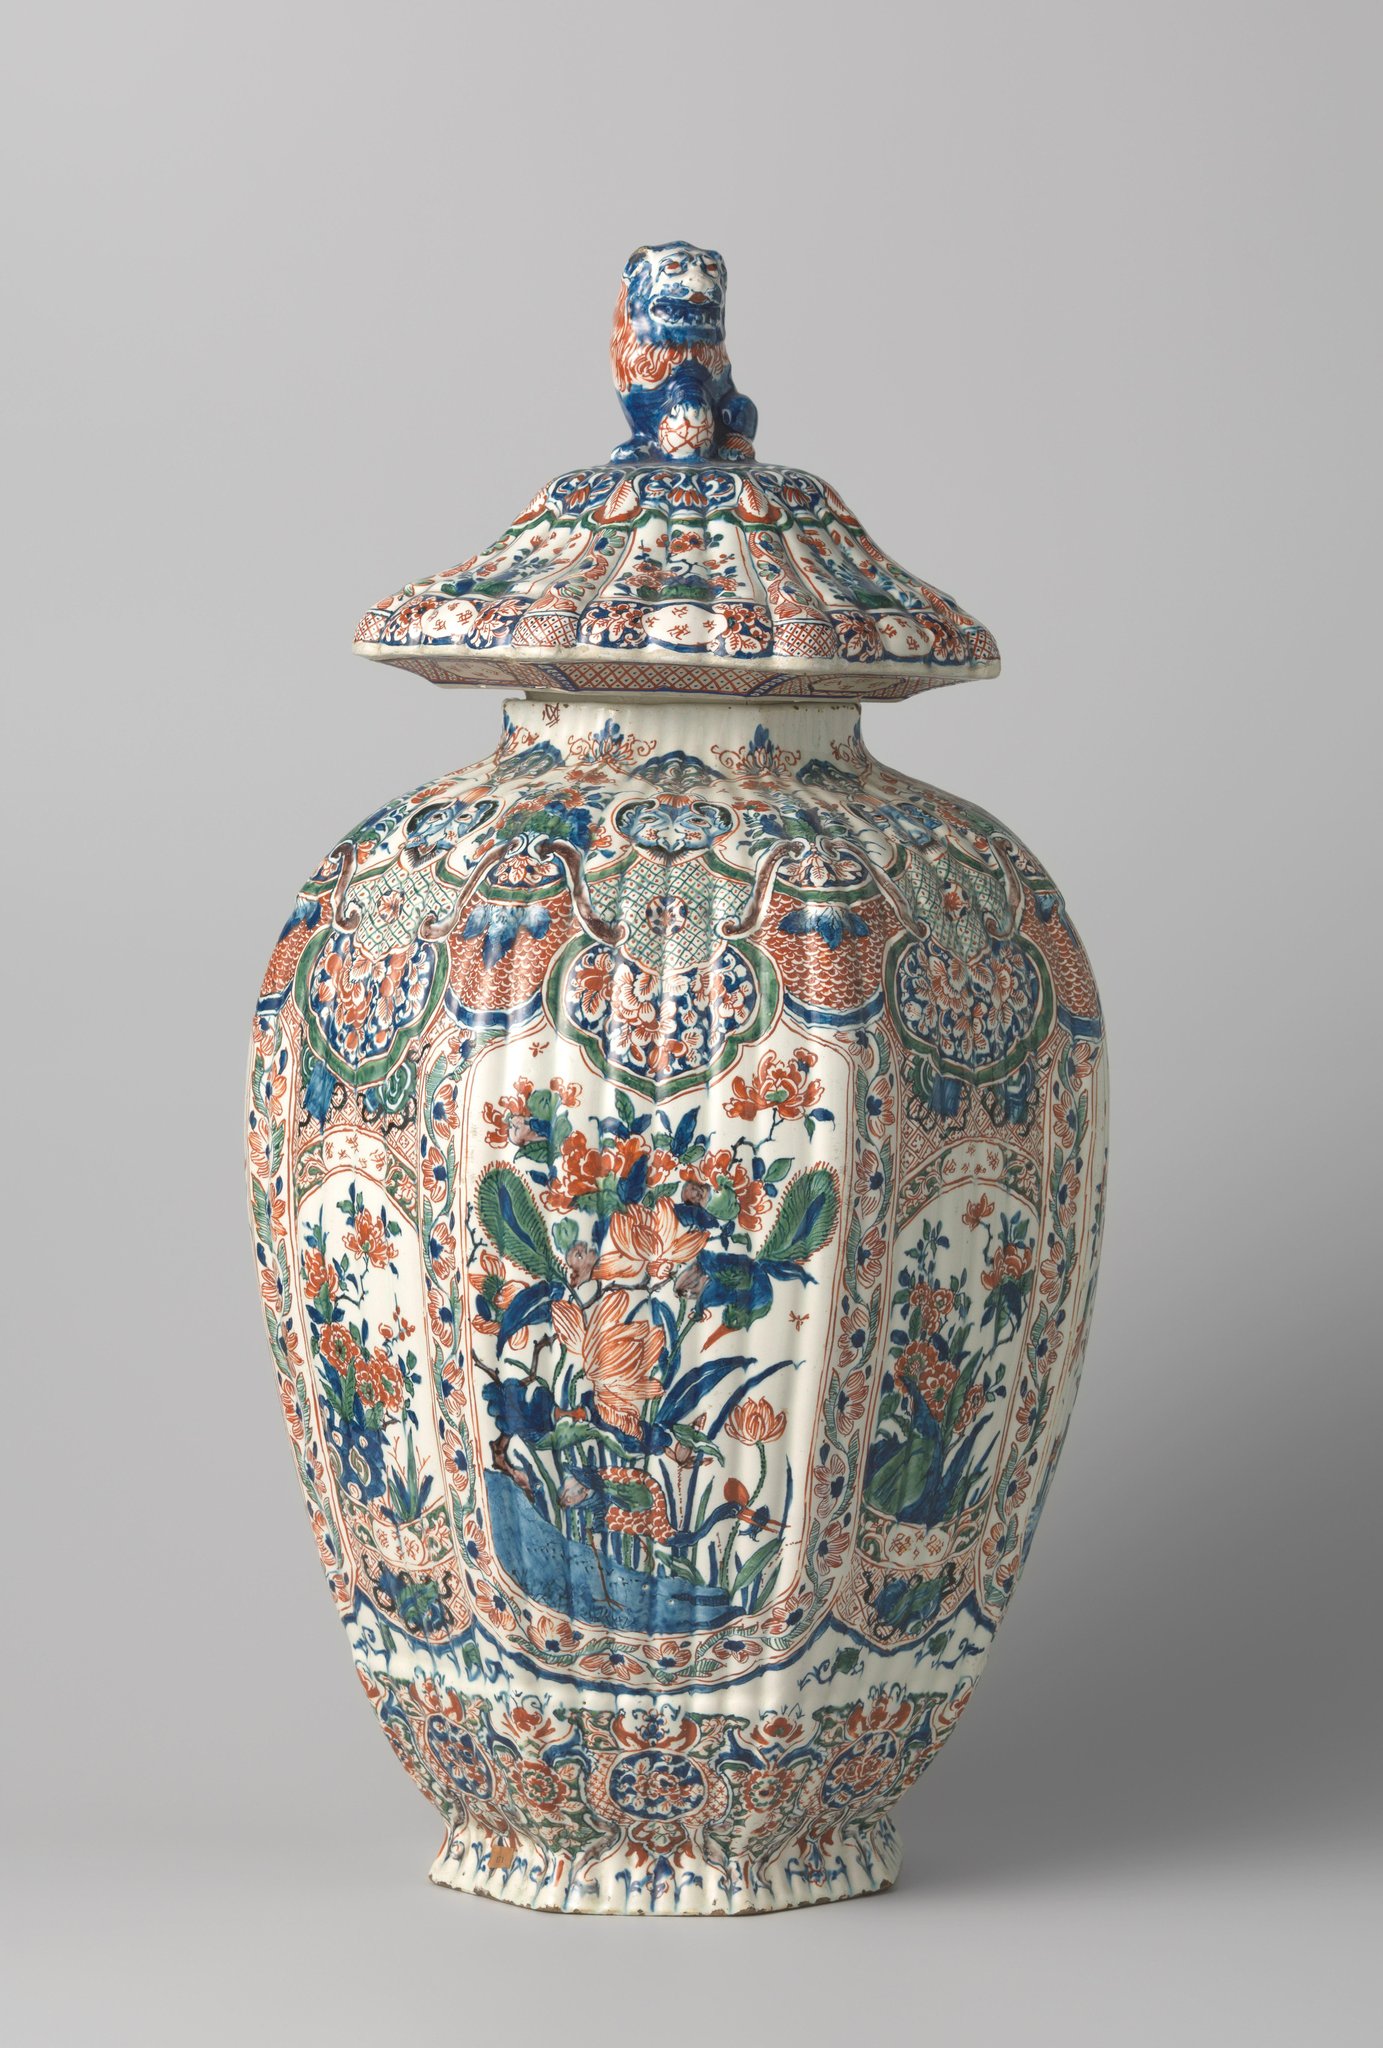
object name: lid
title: Deksel van vaas, veelkleurig beschilderd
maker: Anonymous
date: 1690-1720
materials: faience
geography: delft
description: Deksel van faïence. Veelkleurig beschilderd.